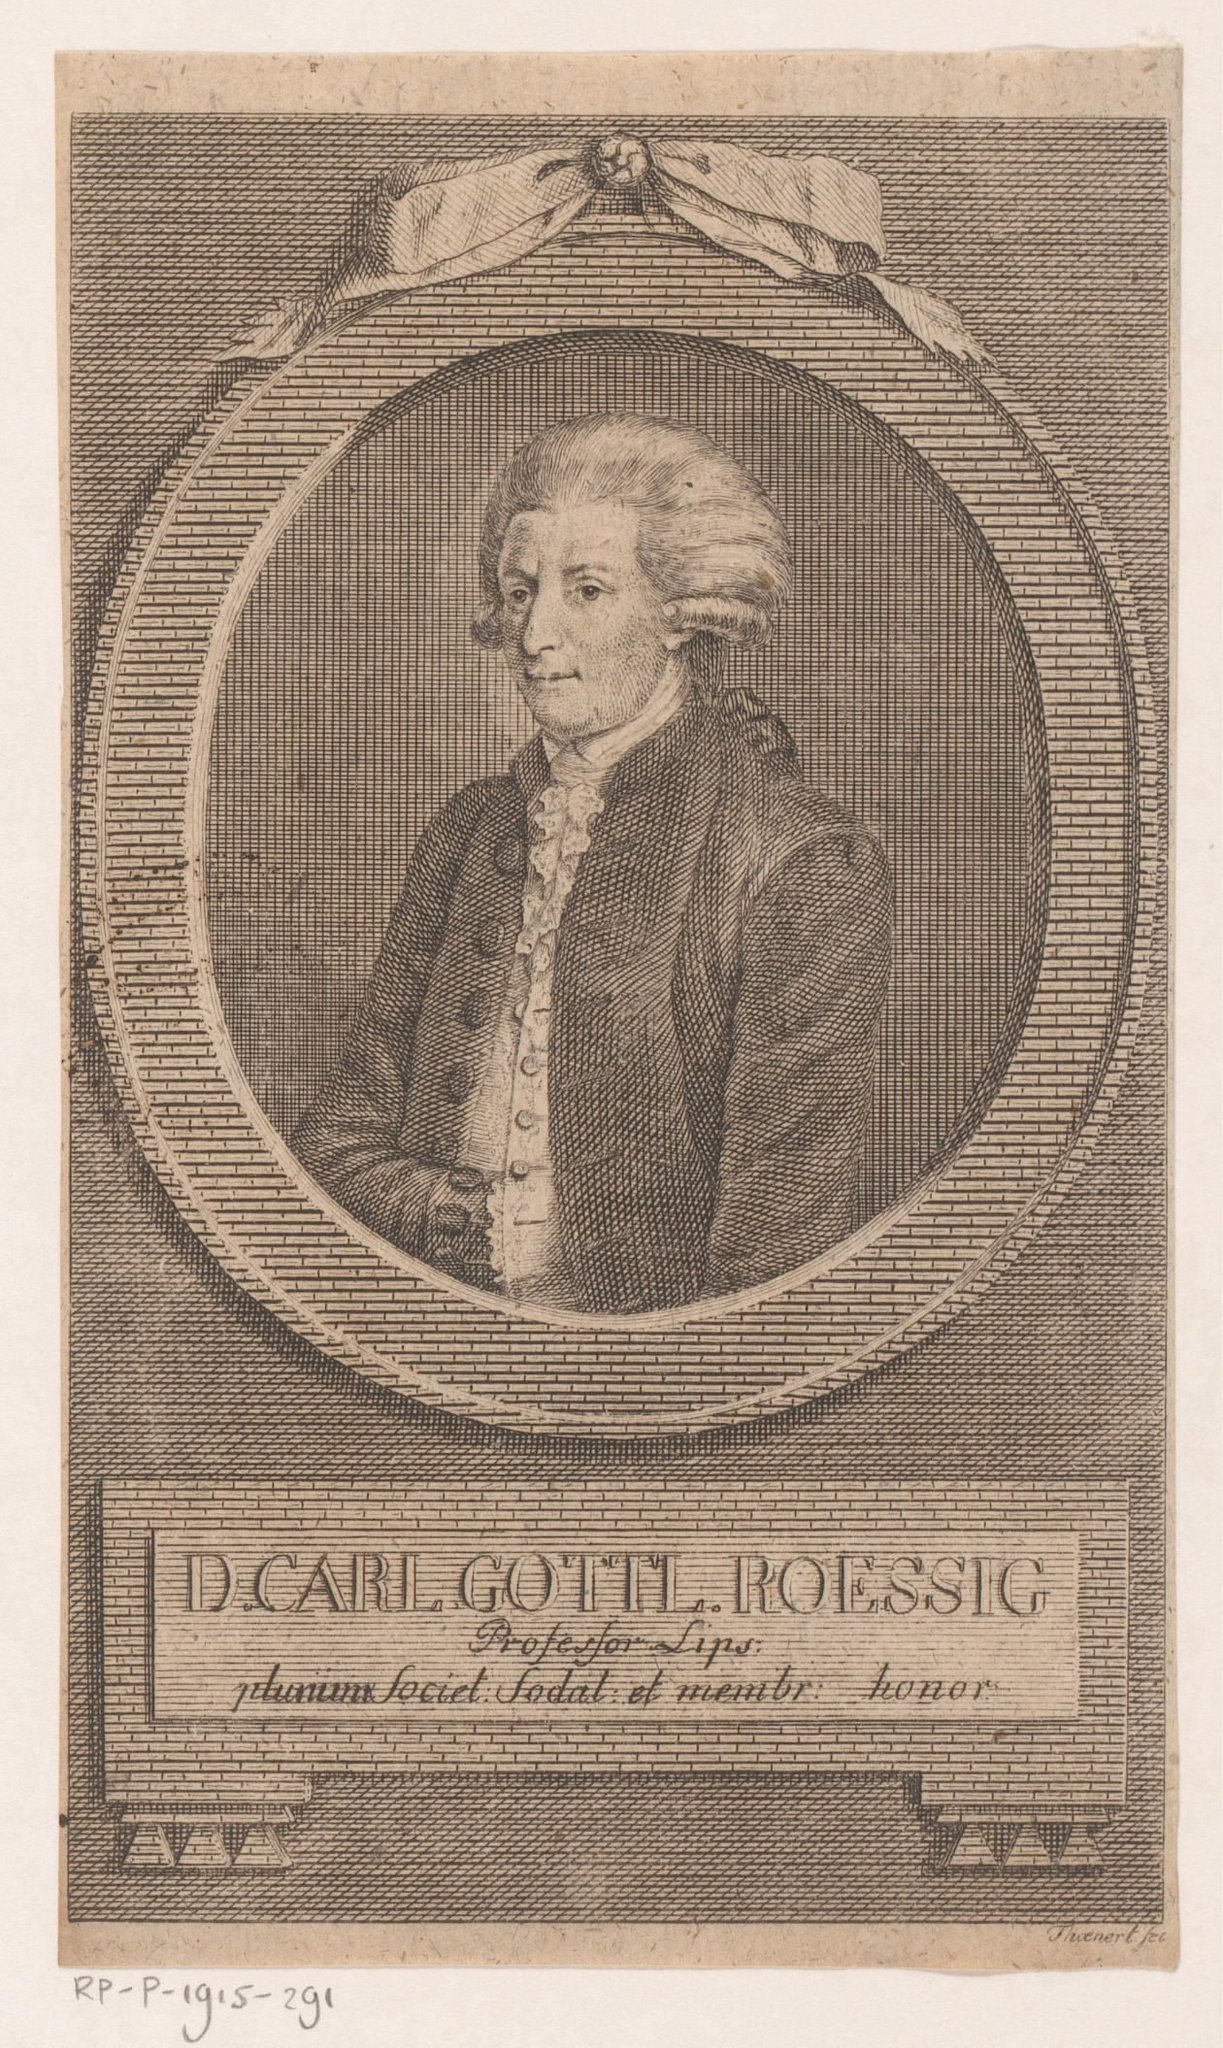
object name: print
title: Portret van Carl Gottlob Rößig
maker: medardus thoenert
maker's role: print maker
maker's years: 1754-1814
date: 1785-1814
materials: paper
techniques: engraving, etching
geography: germany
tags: historical persons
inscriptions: collector's mark: Lugt 2228